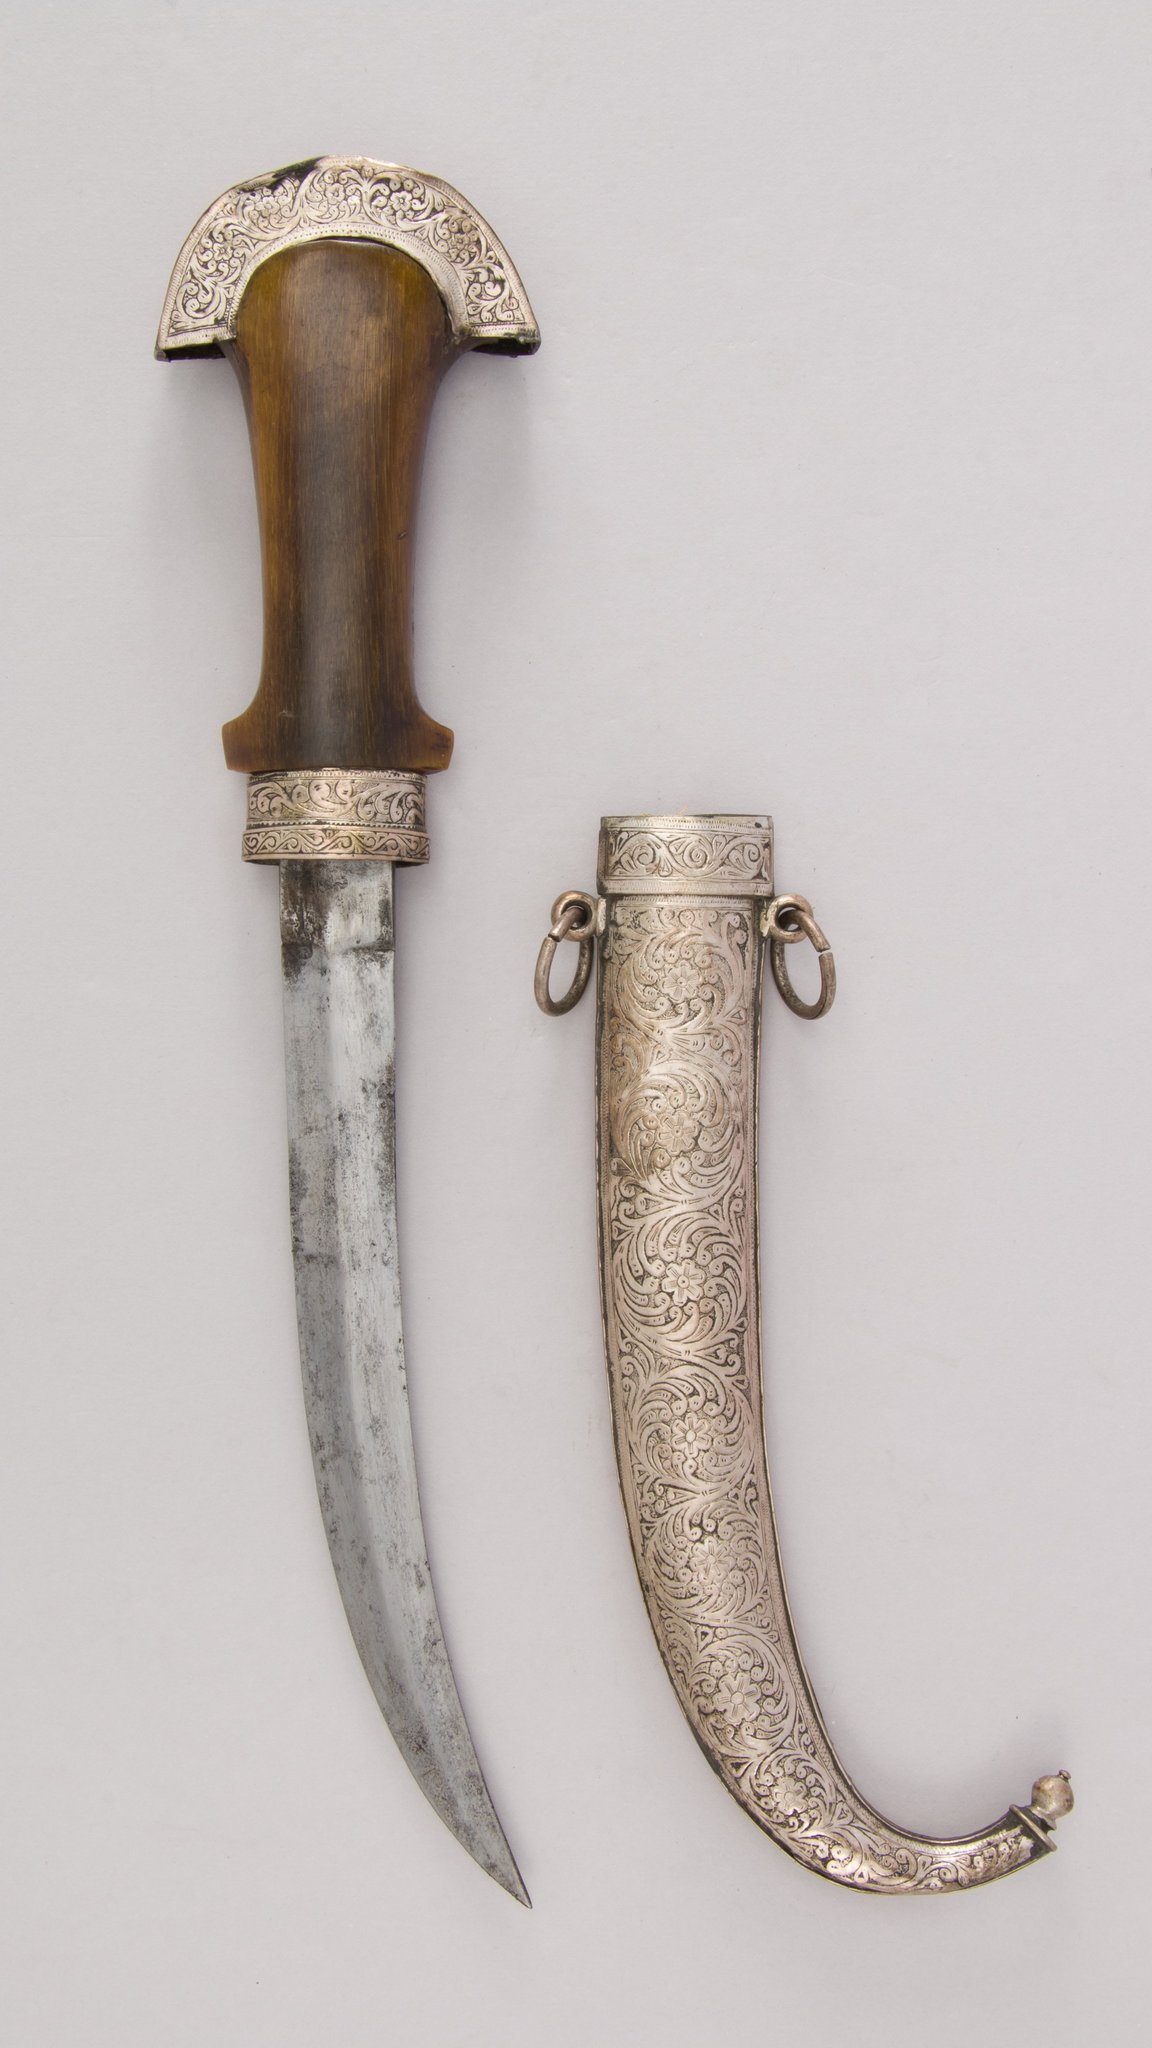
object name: dagger jambiya with sheath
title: Dagger (Jambiya) and Sheath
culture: moroccan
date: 1801-1900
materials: horn, silver, steel, wood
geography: morocco